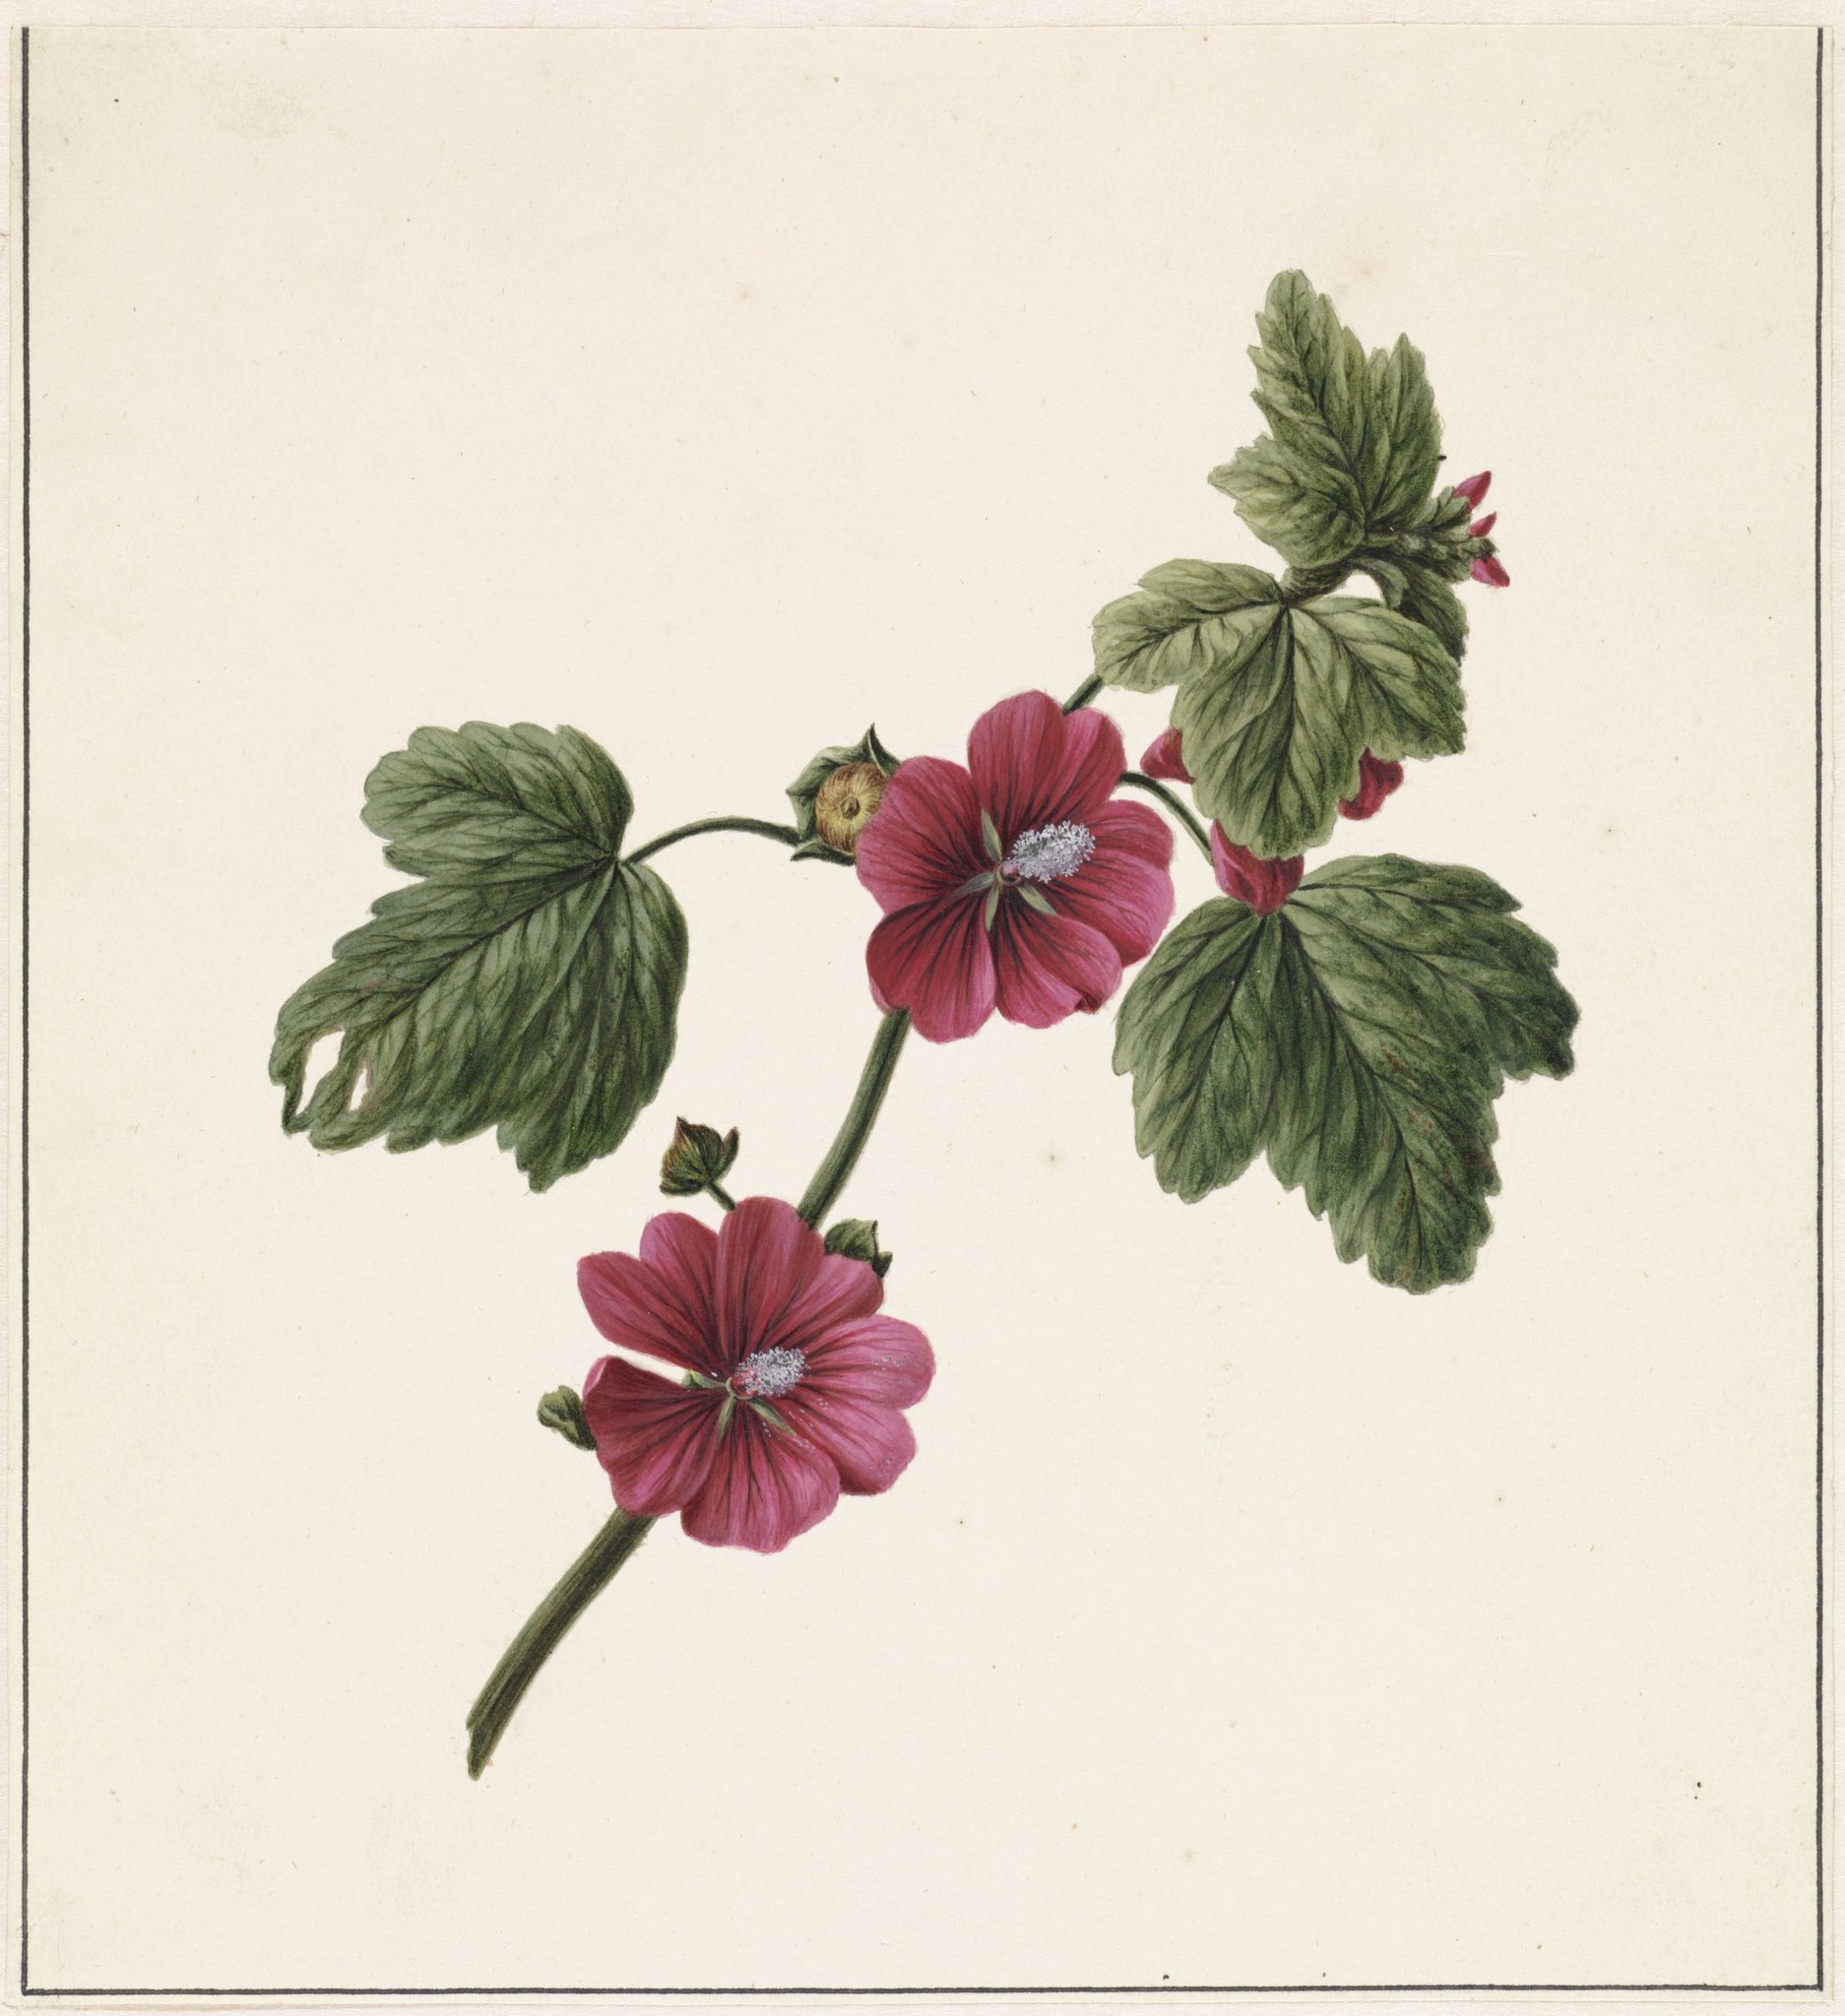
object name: watercolor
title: Branch with Purple Flowers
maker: m. de gijselaar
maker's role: draughtsman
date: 1830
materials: paper, watercolor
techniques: brush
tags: flowers